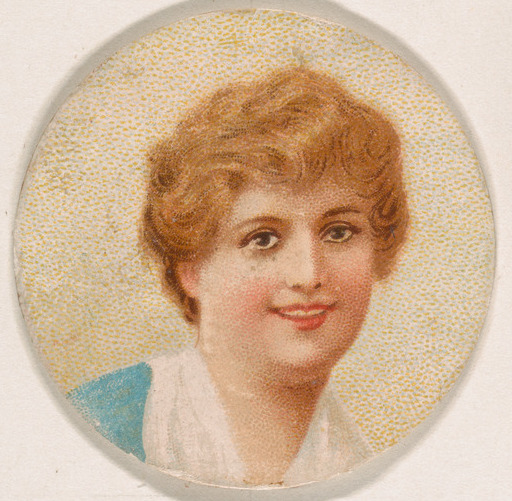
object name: print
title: Portrait of woman, from the Novelties series (N228, Type 1) issued by Kinney Bros.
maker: kinney brothers tobacco company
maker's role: publisher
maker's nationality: american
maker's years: 1869-2011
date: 1889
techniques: color lithograph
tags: portraits,women